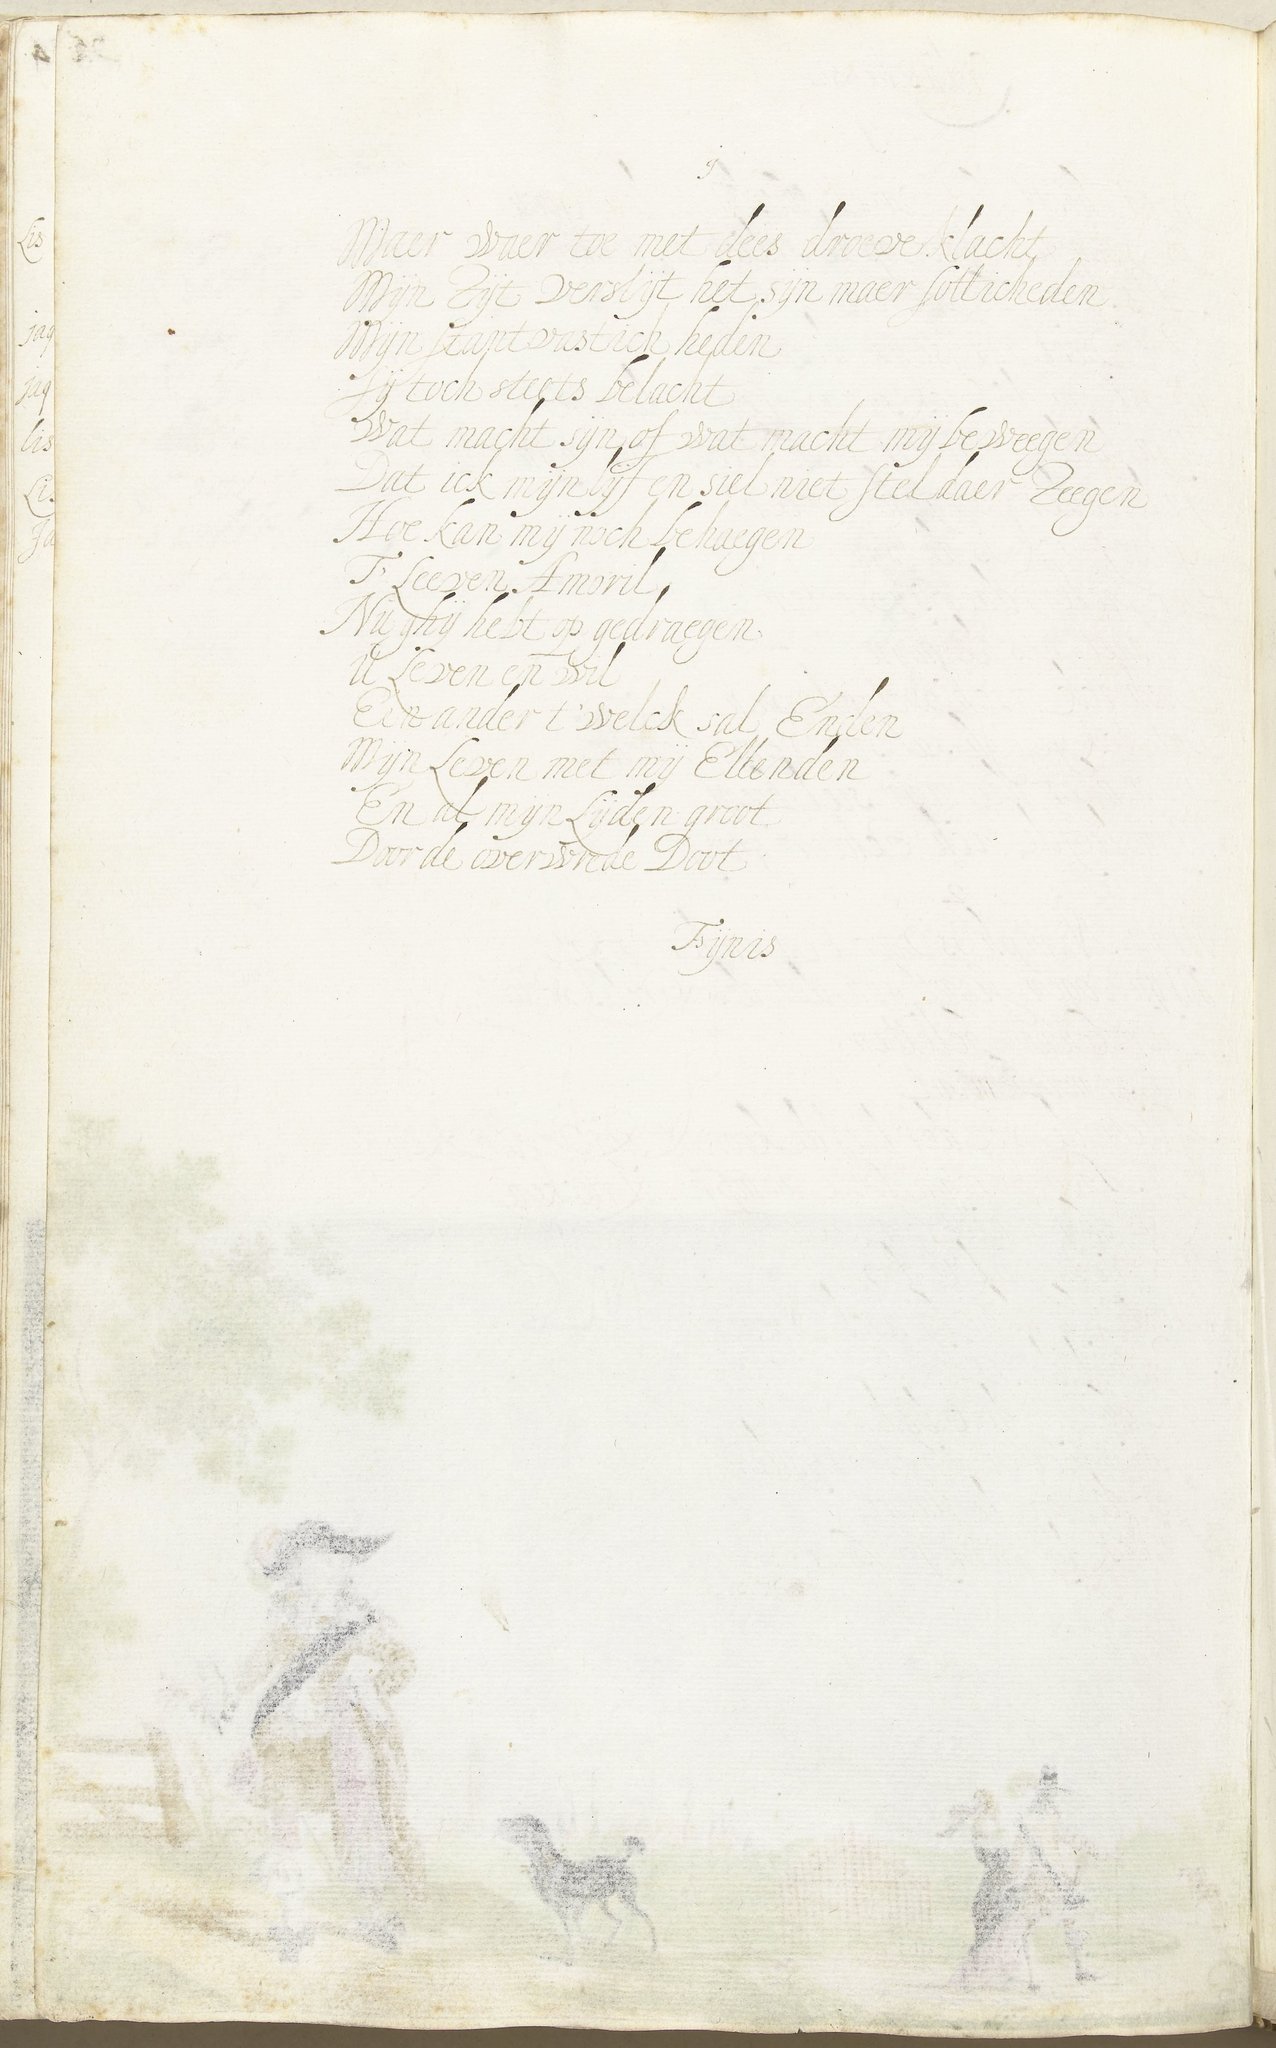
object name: poem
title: Liefdesklacht over Amoril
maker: gesina ter borch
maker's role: draughtsman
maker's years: 1633-1690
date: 1659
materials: ink, paper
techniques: calligraphy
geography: zwolle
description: Vervolg van de liefdesklacht op de voorkant van het blad over de wrede nimf Amoril, op de wijs van Laduschesse.